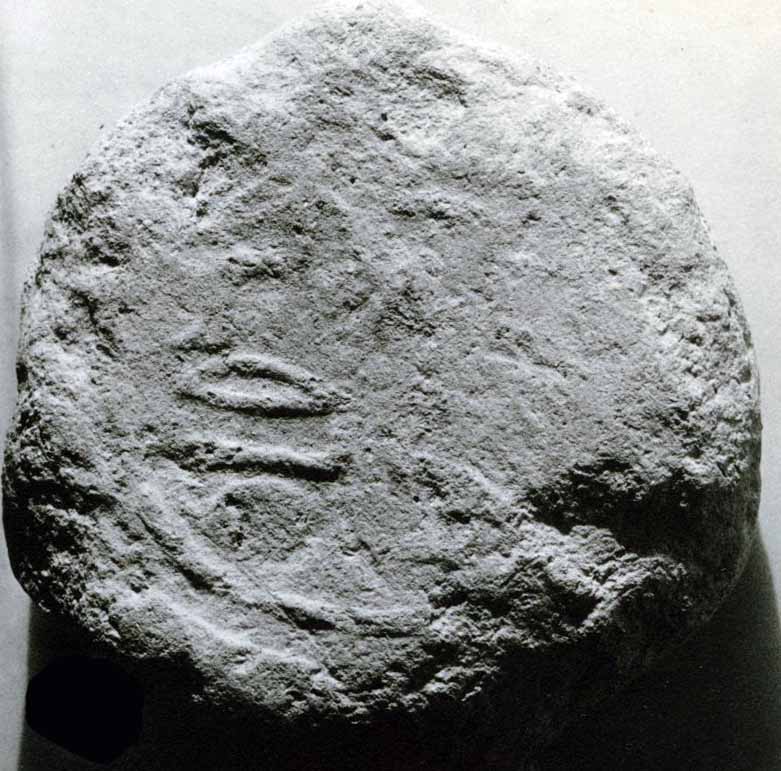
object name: cone, sare, circular impression, child, nursery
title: Funerary Cone of Sare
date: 1550-1295 BCE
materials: pottery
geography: egypt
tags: hieroglyphs